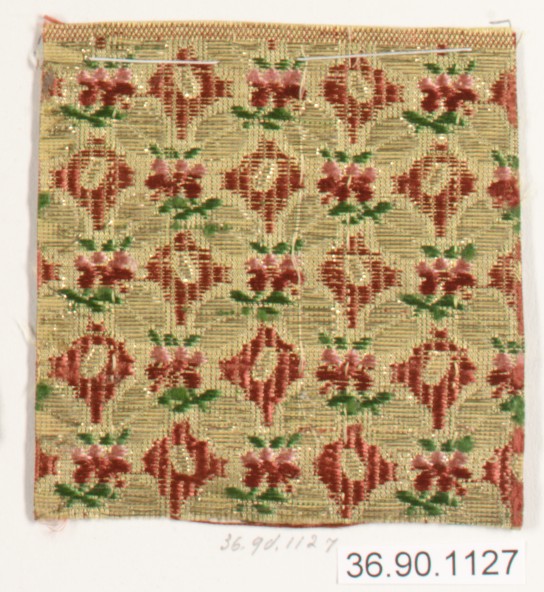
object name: sample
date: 1701-1900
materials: metal thread, silk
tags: flowers